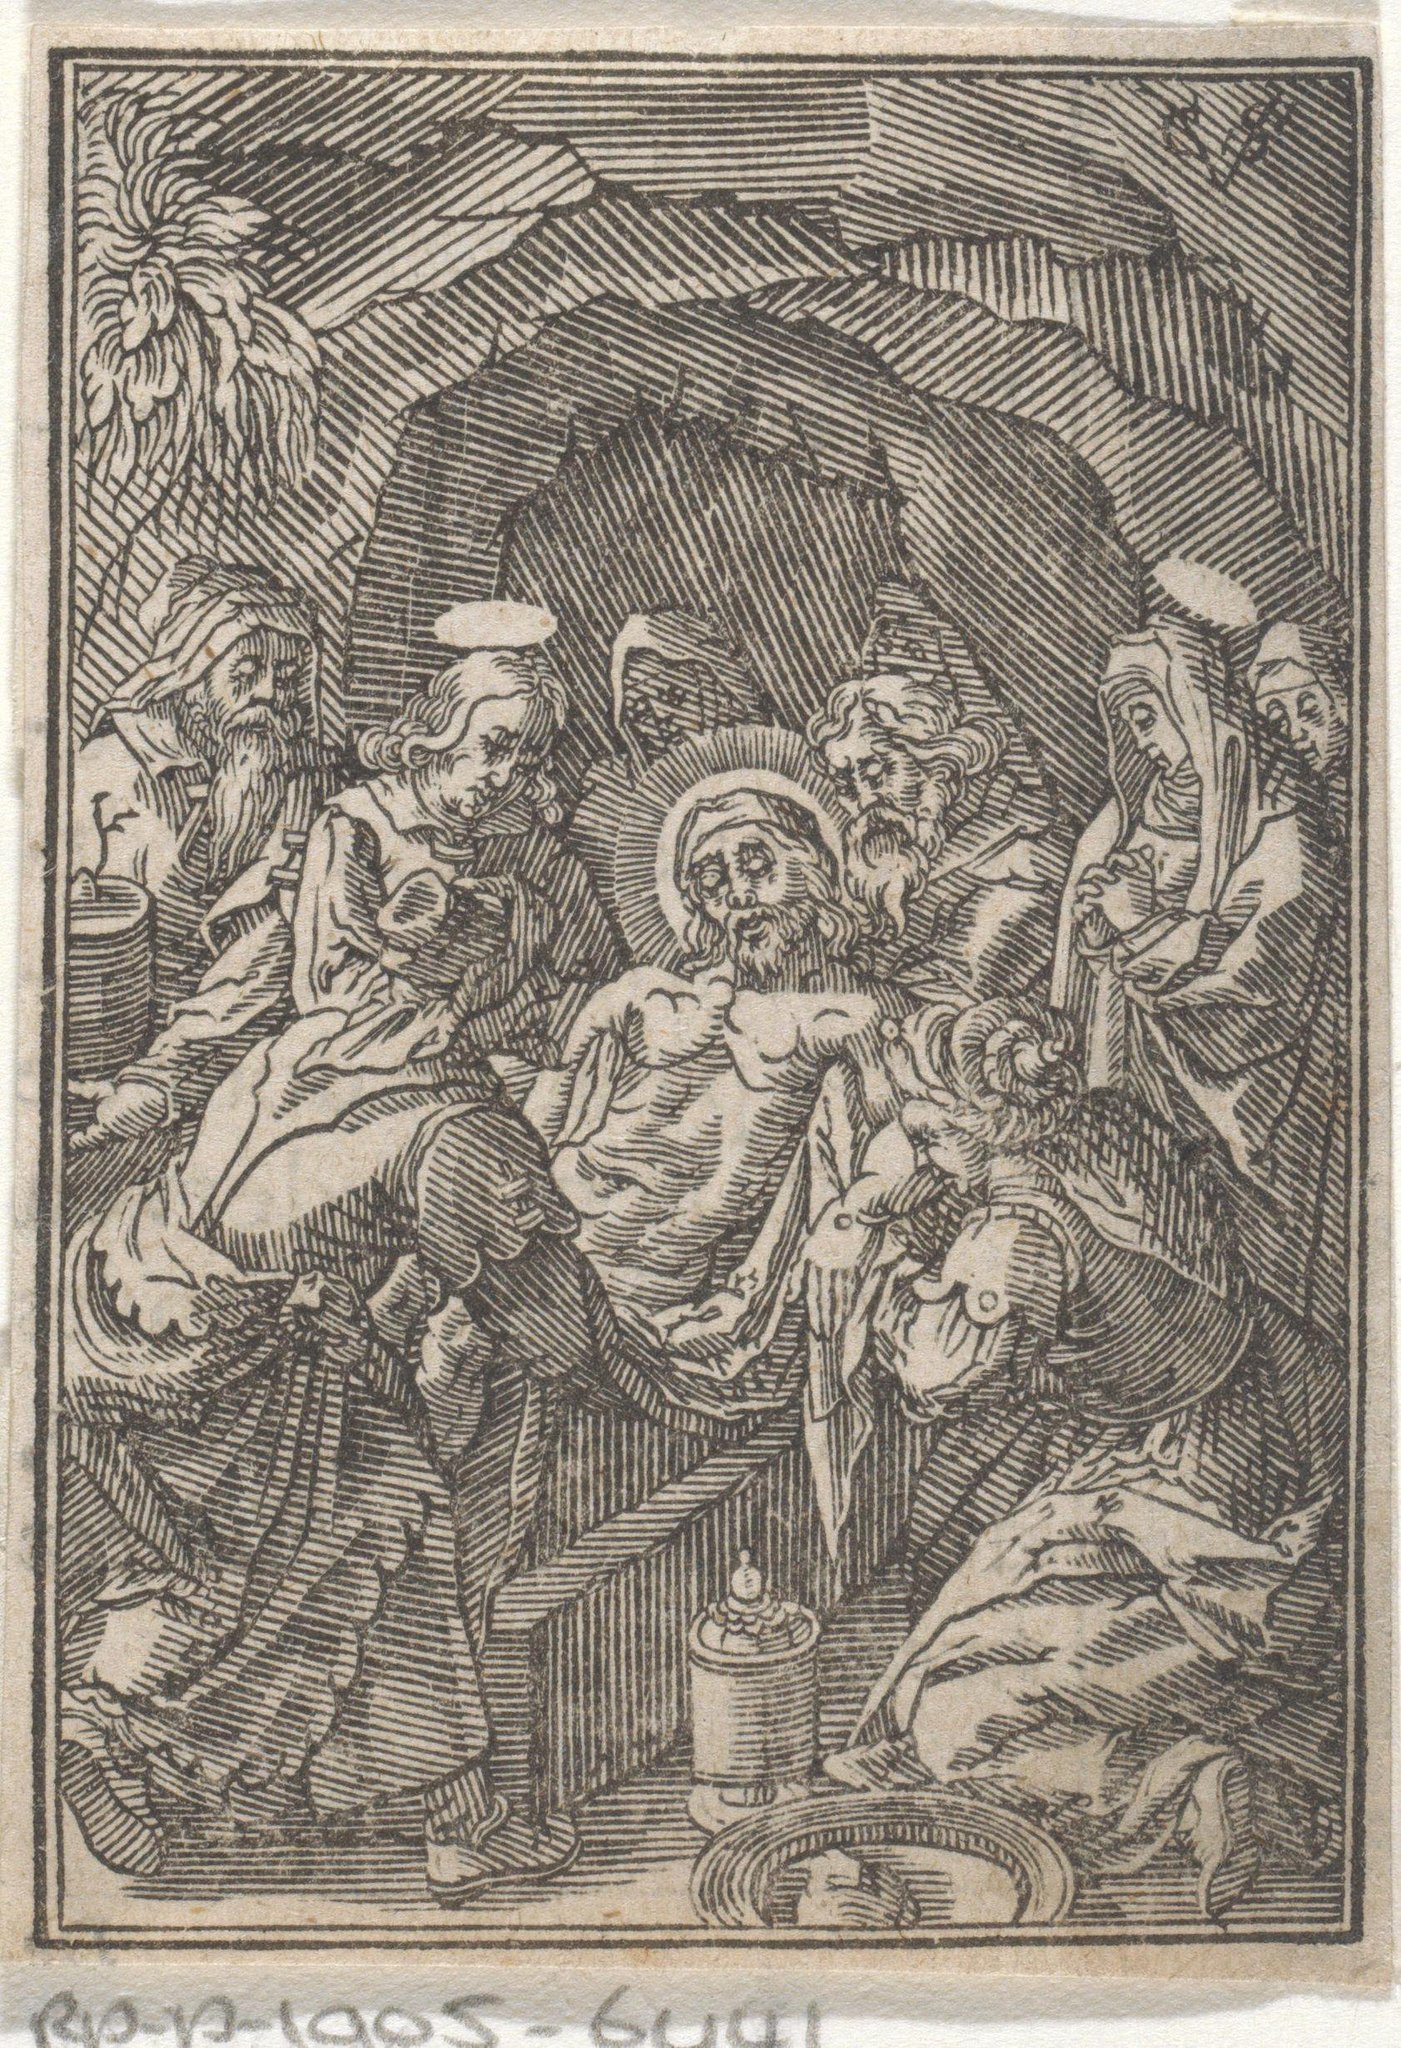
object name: print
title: Graflegging van Christus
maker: christoffel van sichem (ii)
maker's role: print maker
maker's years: 1581-1658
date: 1581-1658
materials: paper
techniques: letterpress printing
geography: amsterdam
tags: christ's entombment (possibly by angels)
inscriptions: collector's mark: Lugt 2228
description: Christus wordt door een aantal mannen in een graf gelegd in een grot. Rondom zijn lichaam treuren Maria, Johannes en Maria Magdalena.